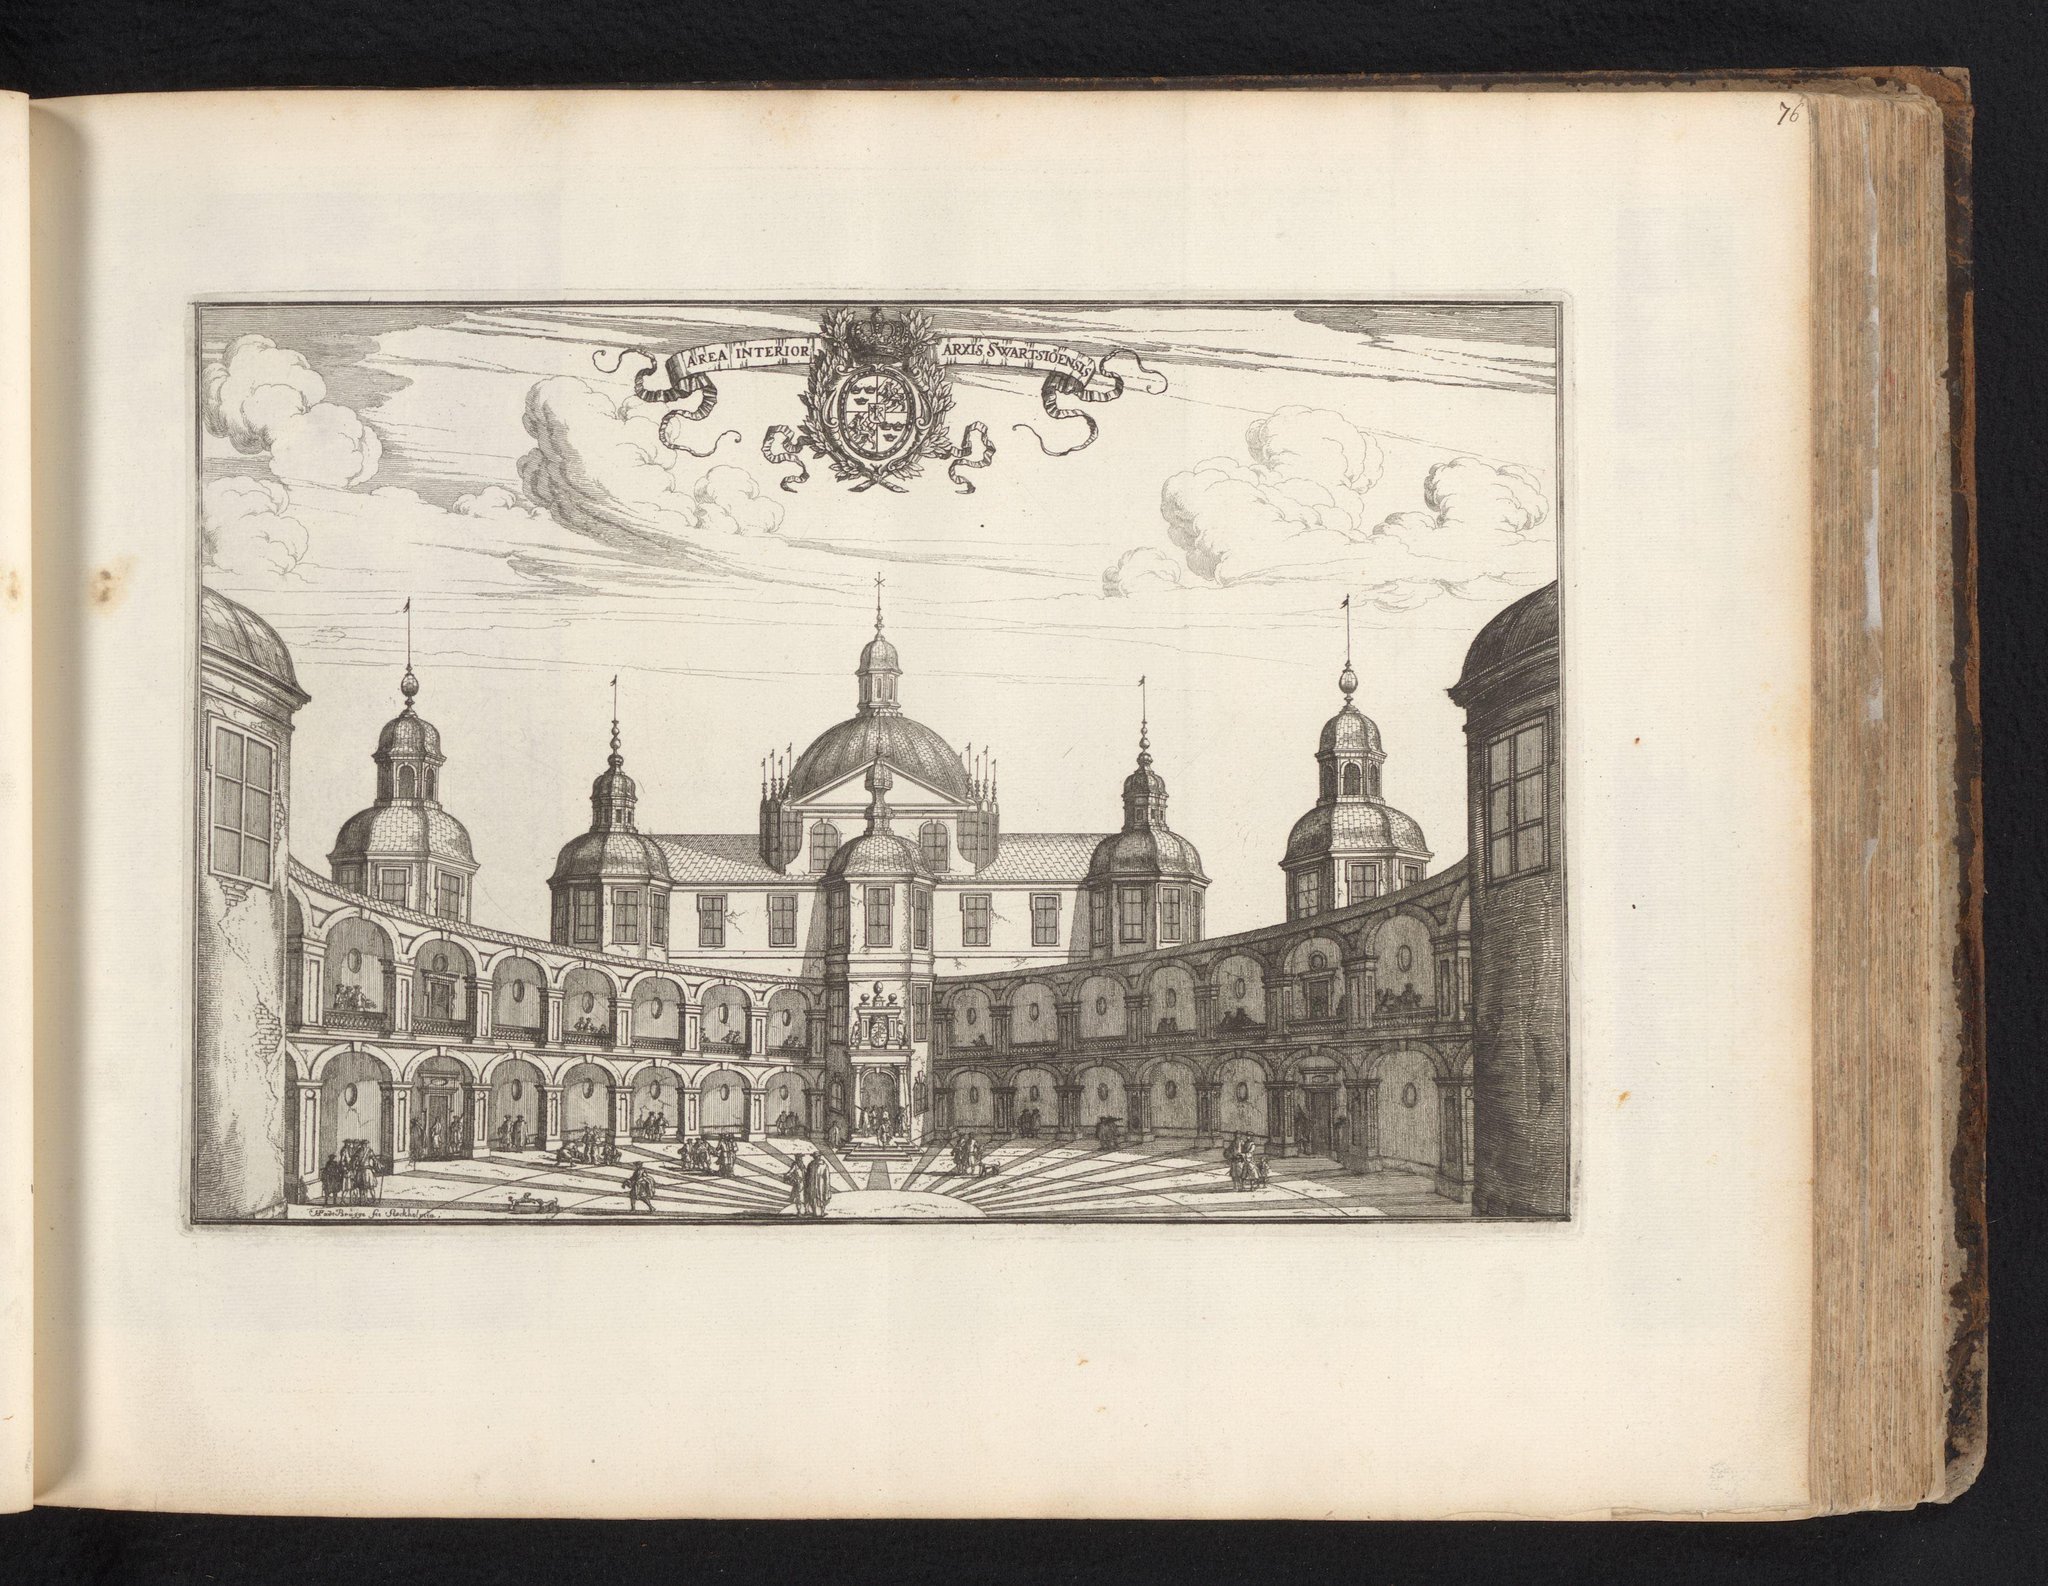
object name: print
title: Suecia Antiqua et Hodierna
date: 1686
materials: paper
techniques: etching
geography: stockholm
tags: palace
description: Kungliga Biblioteket, 'Suecia': http://www.kb.se/samlingarna/Kartor-bilder/Suecia-antiqua/ (geraadpleegd november 2016).